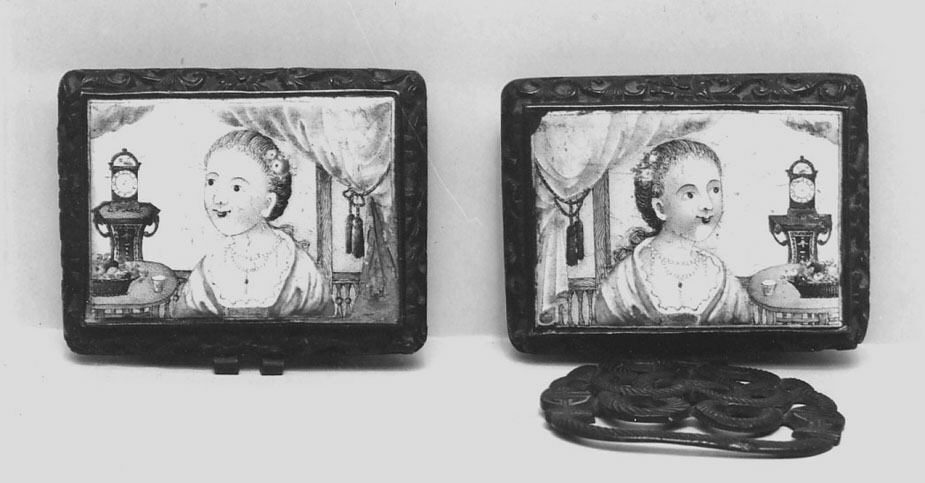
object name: buckle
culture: chinese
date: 1736-1795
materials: enamel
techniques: painting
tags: women